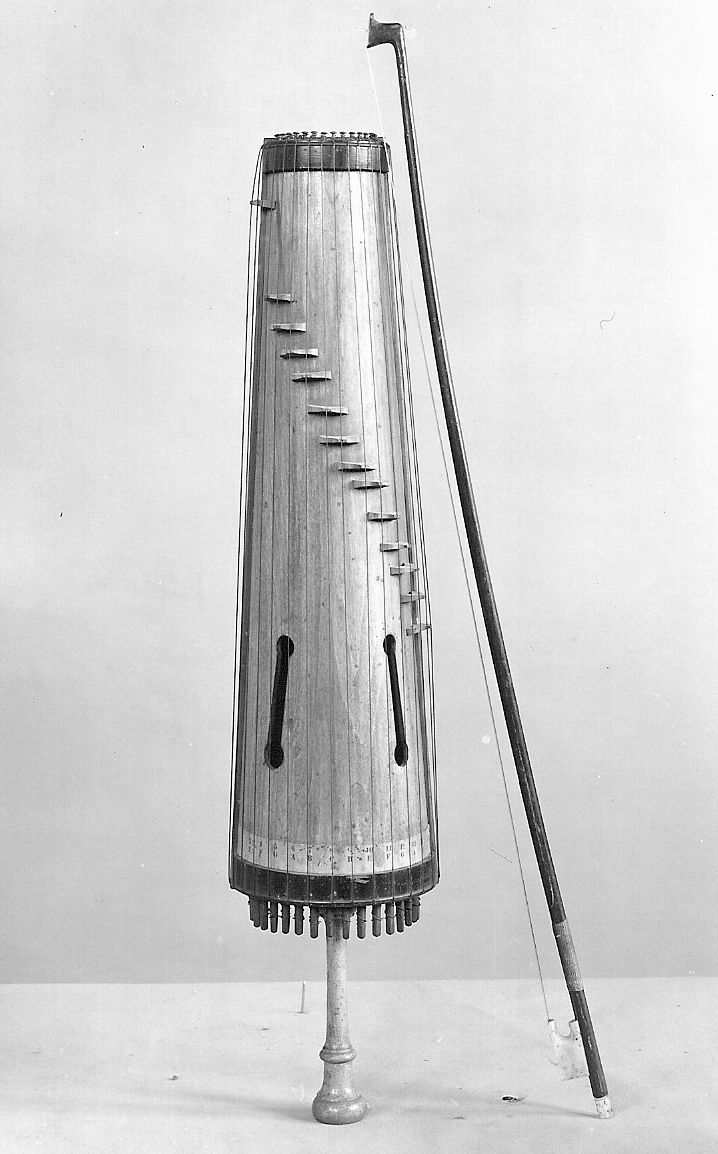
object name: alexander violin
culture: american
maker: sylvanus j. talbott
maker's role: inventor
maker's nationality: american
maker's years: 1838-1924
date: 1867-1900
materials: wood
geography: united states